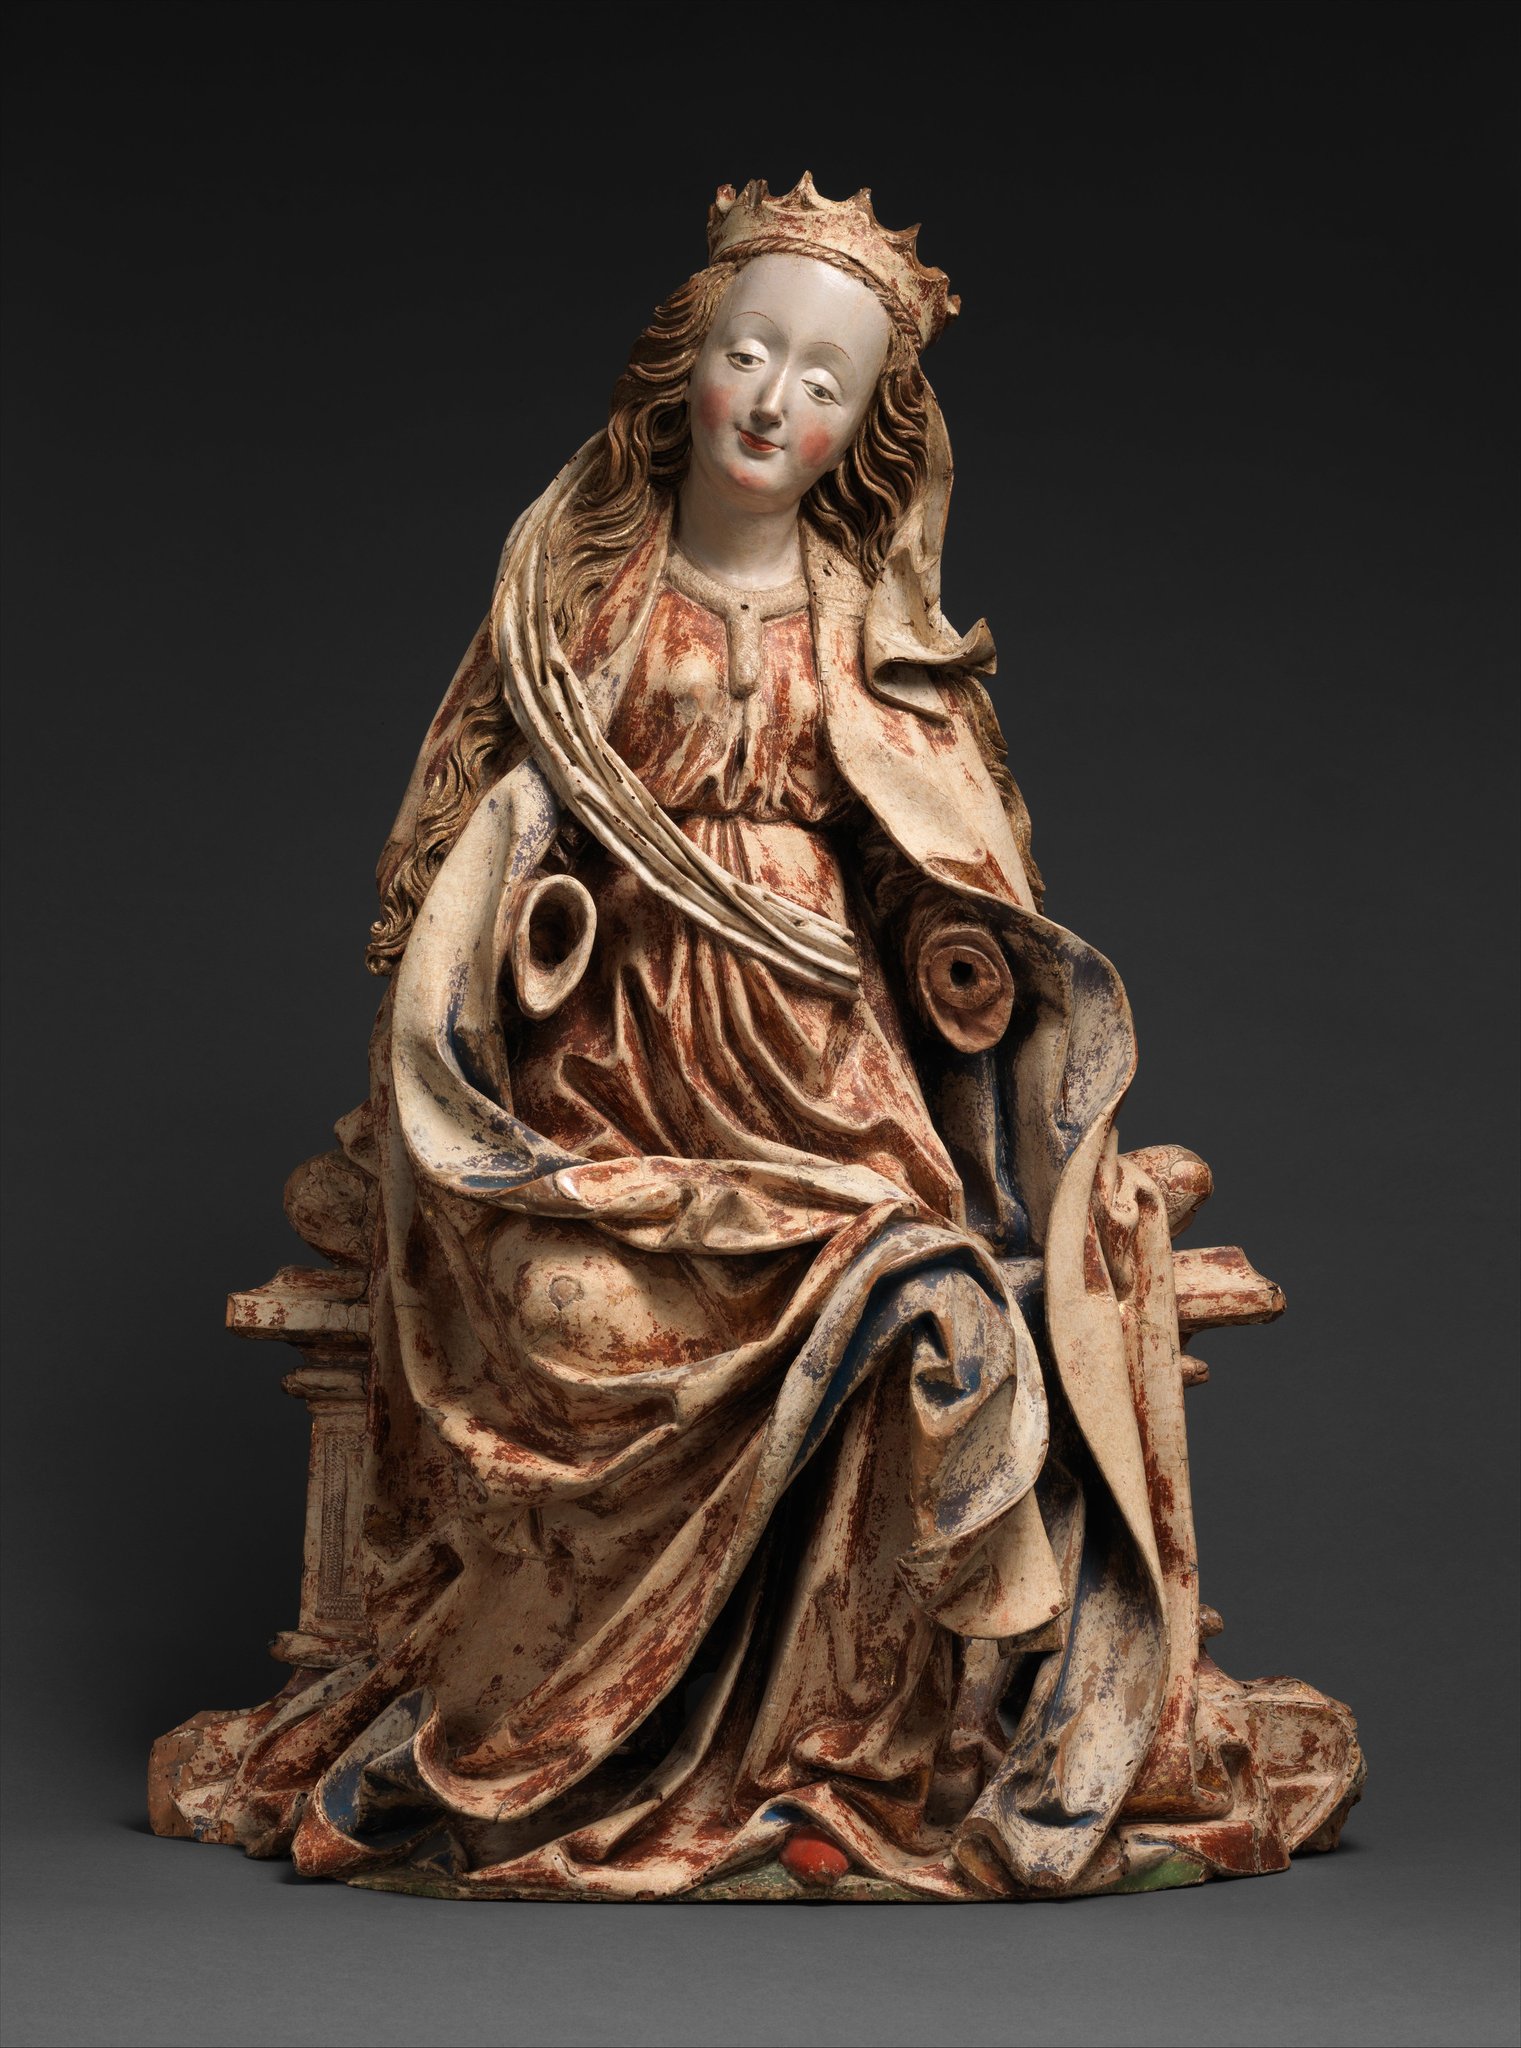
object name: statuette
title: Enthroned Virgin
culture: austrian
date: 1490-1500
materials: gesso, paint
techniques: gilding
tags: virgin mary